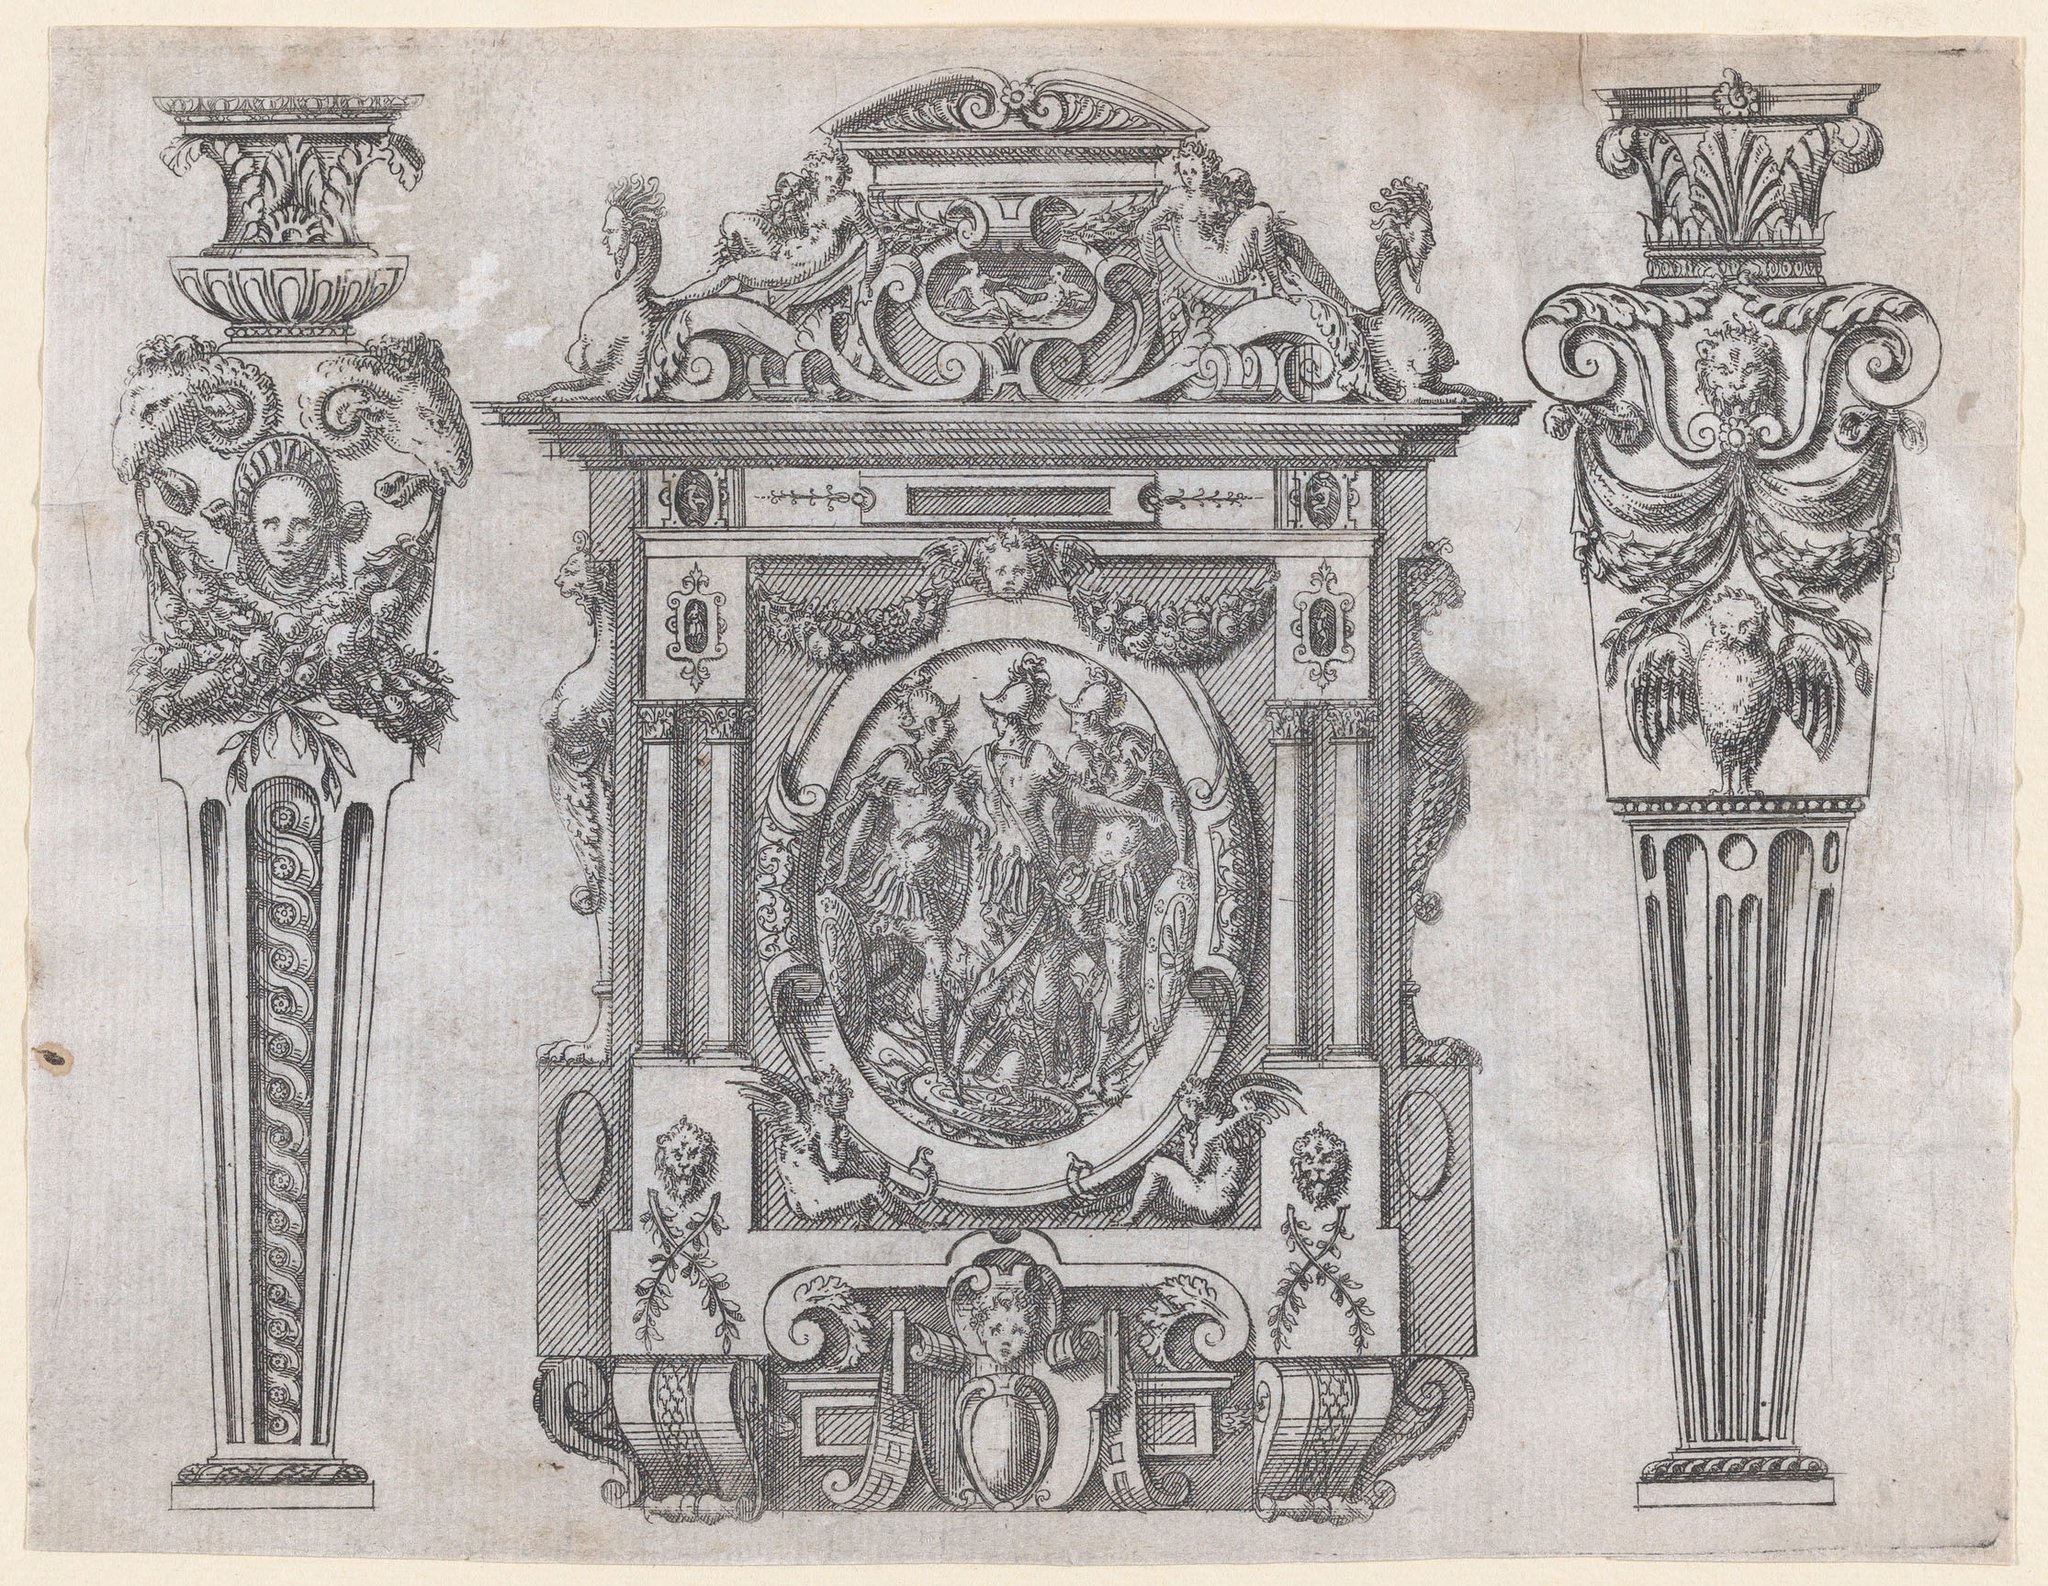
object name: print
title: Furniture Design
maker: jacques androuet du cerceau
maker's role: artist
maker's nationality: french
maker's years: 1510-1585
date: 1565-1570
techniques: etching